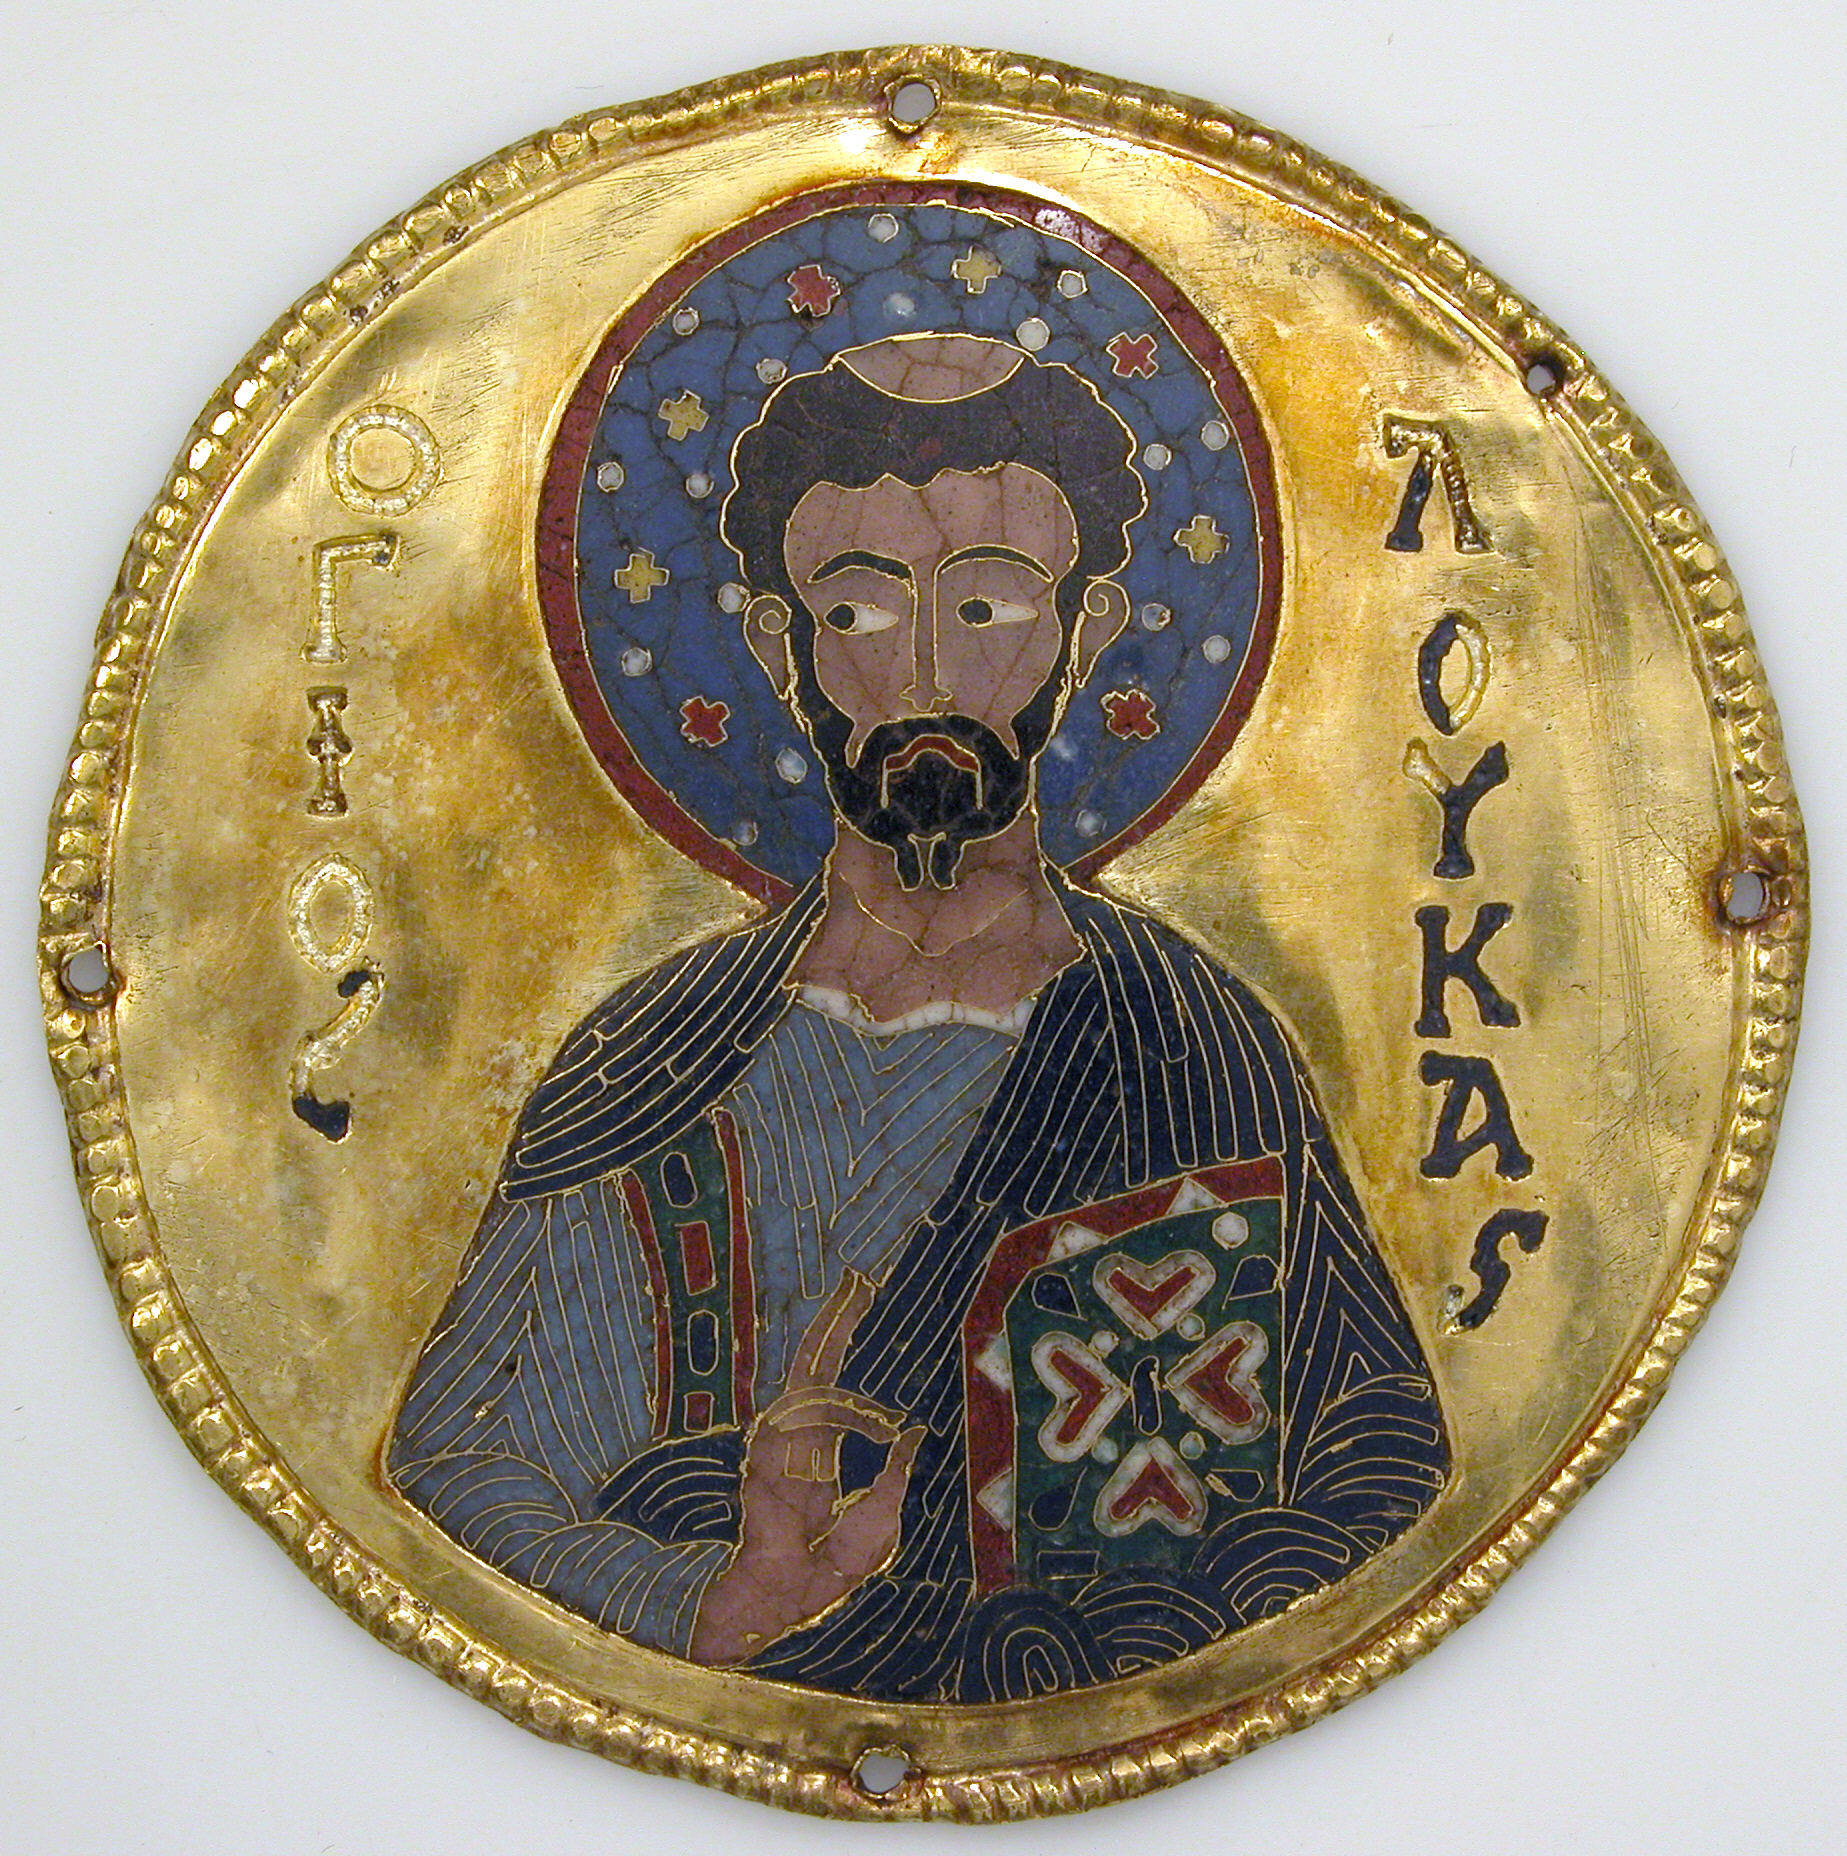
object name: medallion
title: Medallion with Saint Luke from an Icon Frame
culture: byzantine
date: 1100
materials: enamel, gold, silver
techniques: enamel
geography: constantinople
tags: men,saints